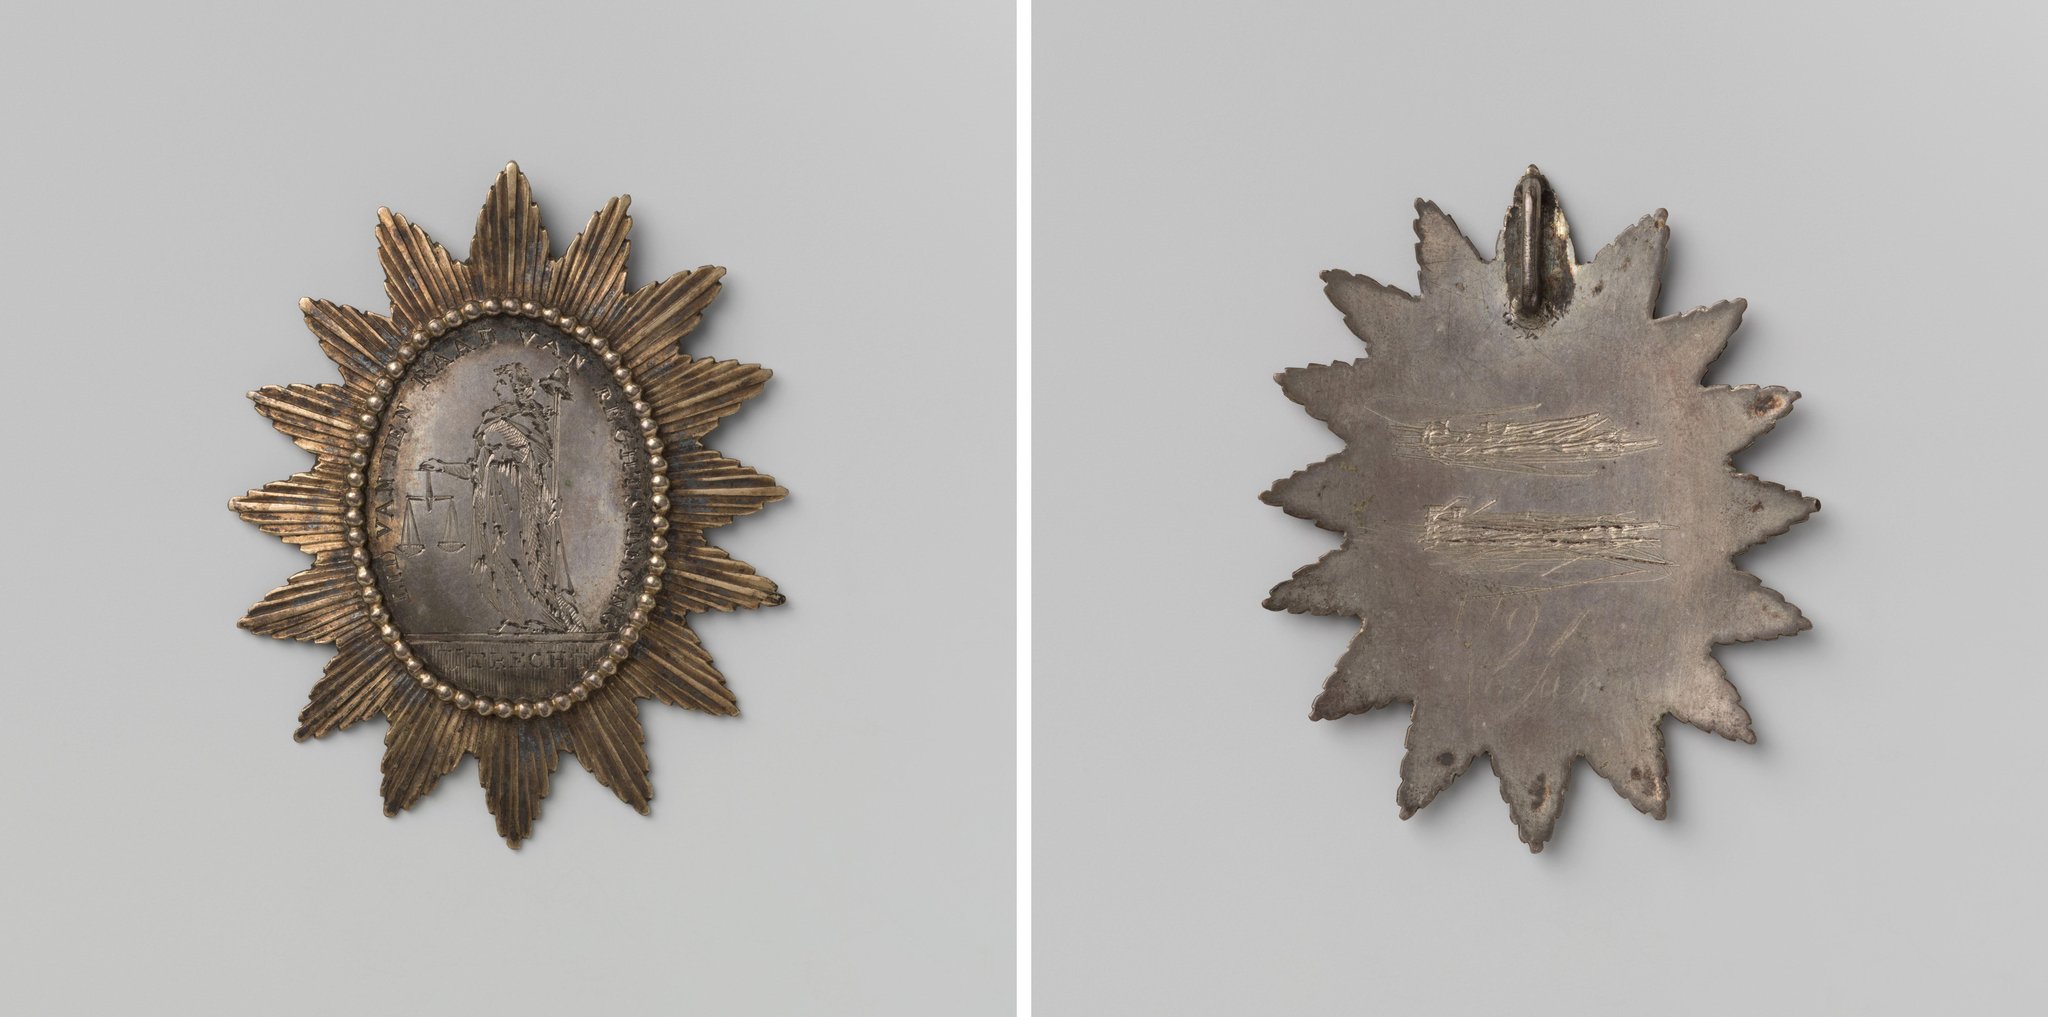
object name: identification medal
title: Lid van de raad van rechtspleging te Utrecht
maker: Anonymous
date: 1797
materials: silver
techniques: engraving, gilding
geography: utrecht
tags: utrecht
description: Zilveren penning in kabelrand en vergulde stralenkrans met zestien punten. Voorzijde: Gerechtigheid met vrijheidsmuts op speer in linker- en weegschaal in rechterhand binnen omschrift; afsnede: opschrift. Keerzijde: draagoog boven doorgekraste naam en jaartal.